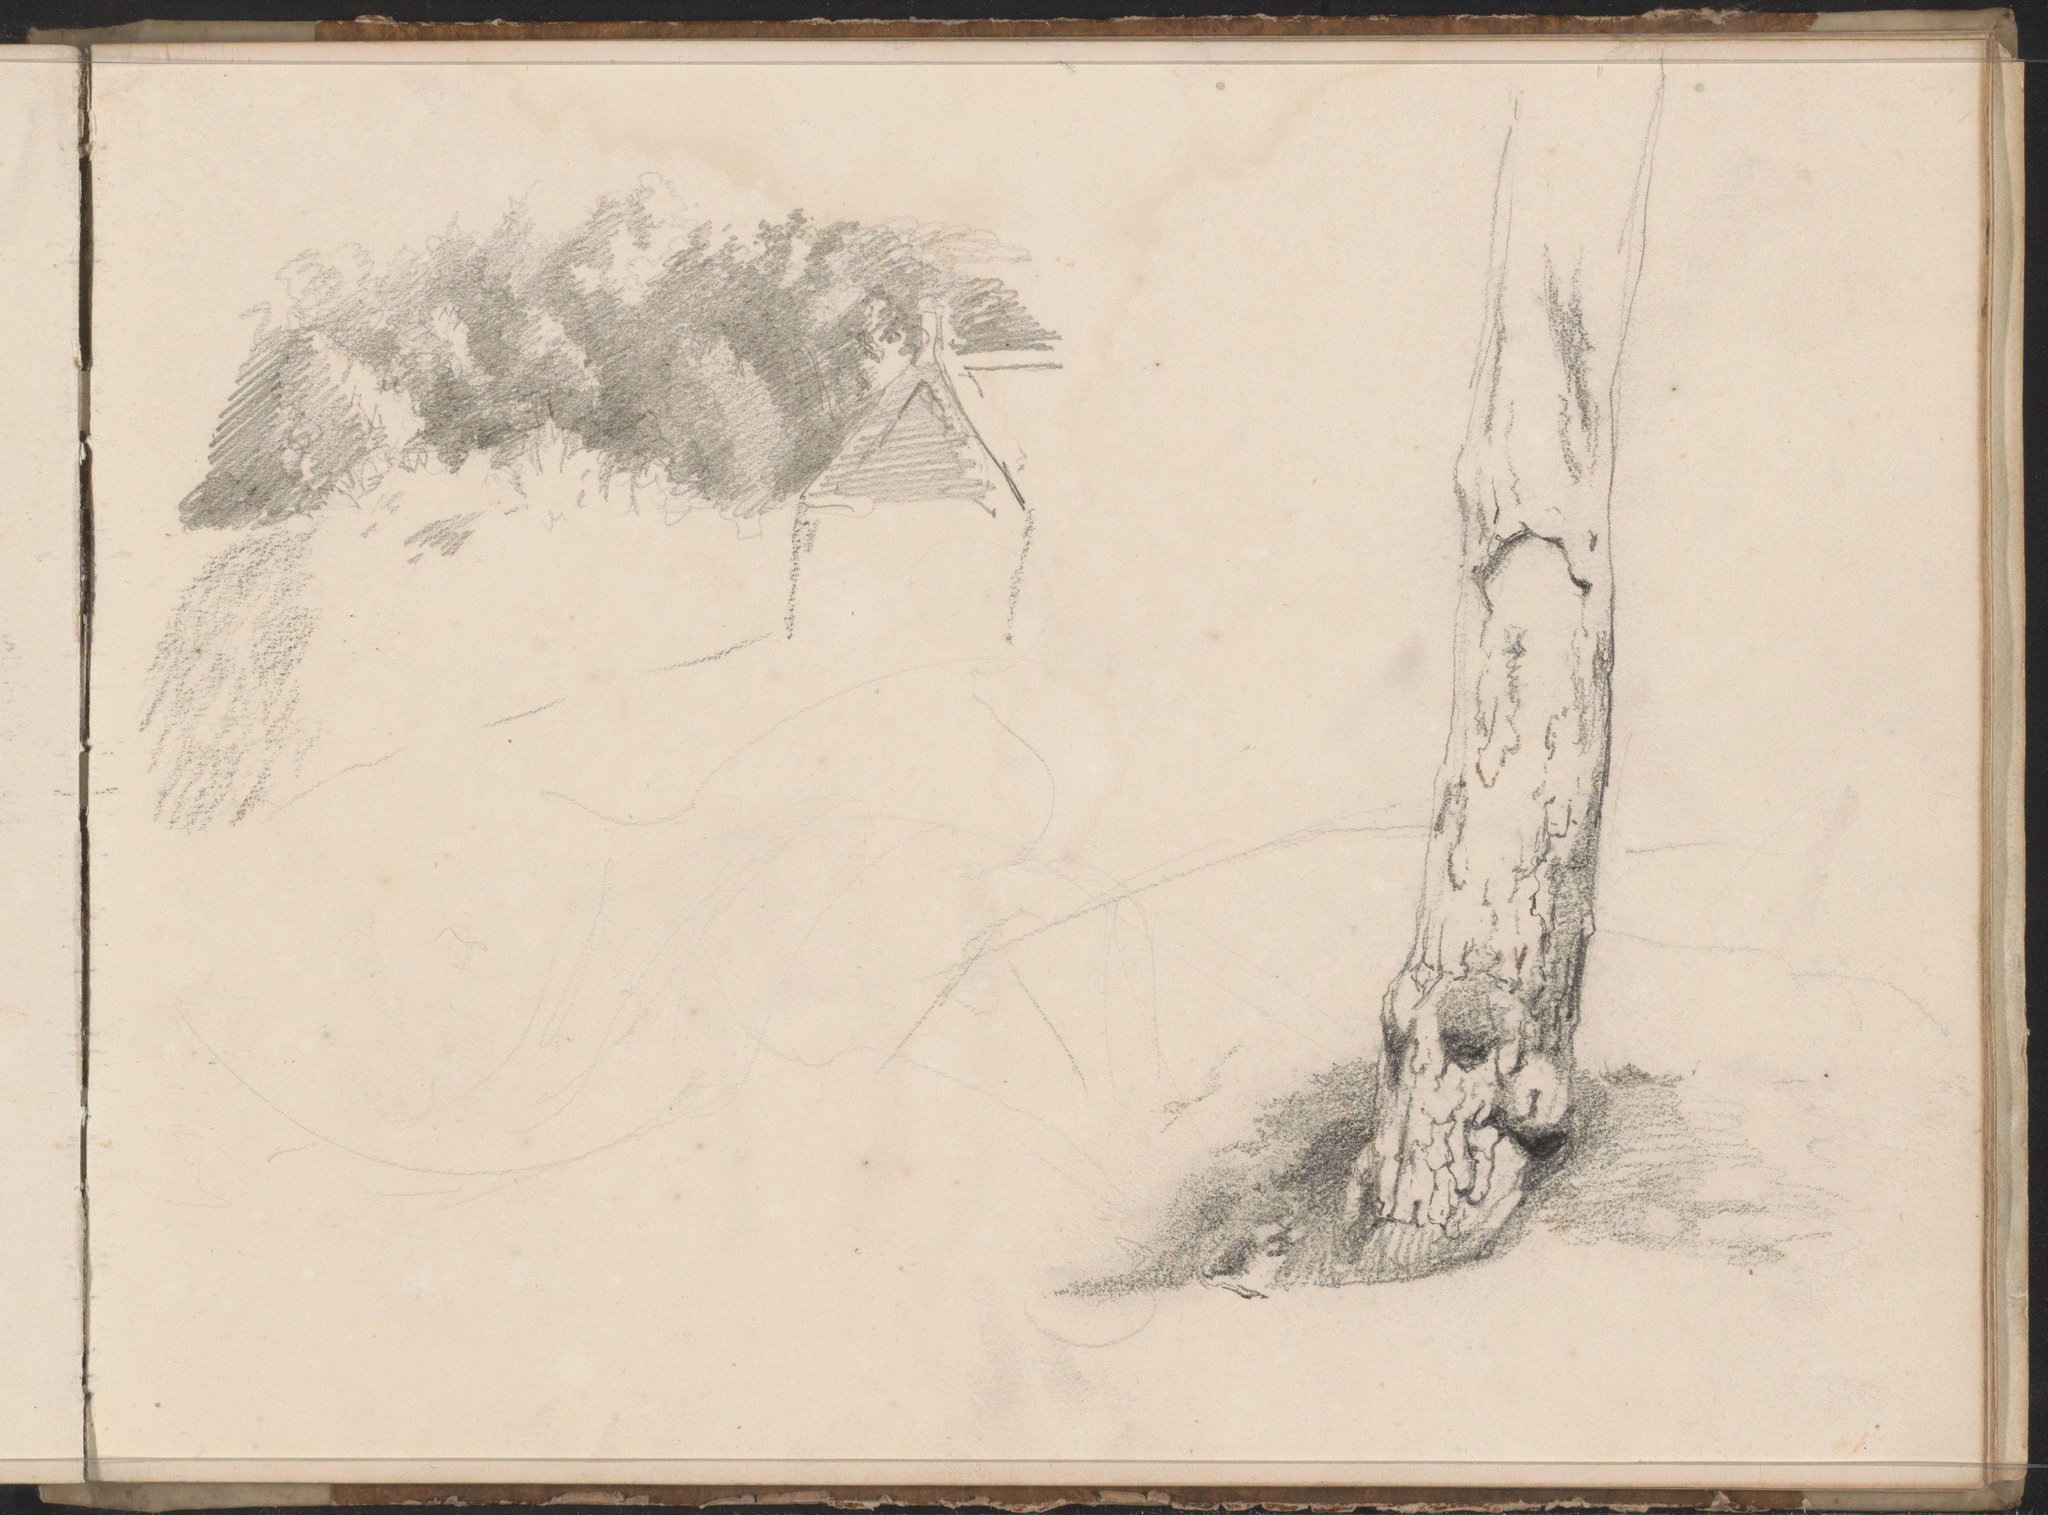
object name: sketchbook leaf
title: Boomstam en een huis naast een bos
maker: maria vos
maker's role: draughtsman, painter, print maker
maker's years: 1824-1906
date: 1834-1906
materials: paper, pencil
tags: rural housing, e.g. country-house, villa, cottage, trees (+ stem, trunk), forest, wood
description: Blad 27 recto uit een schetsboek met 39 bladen.